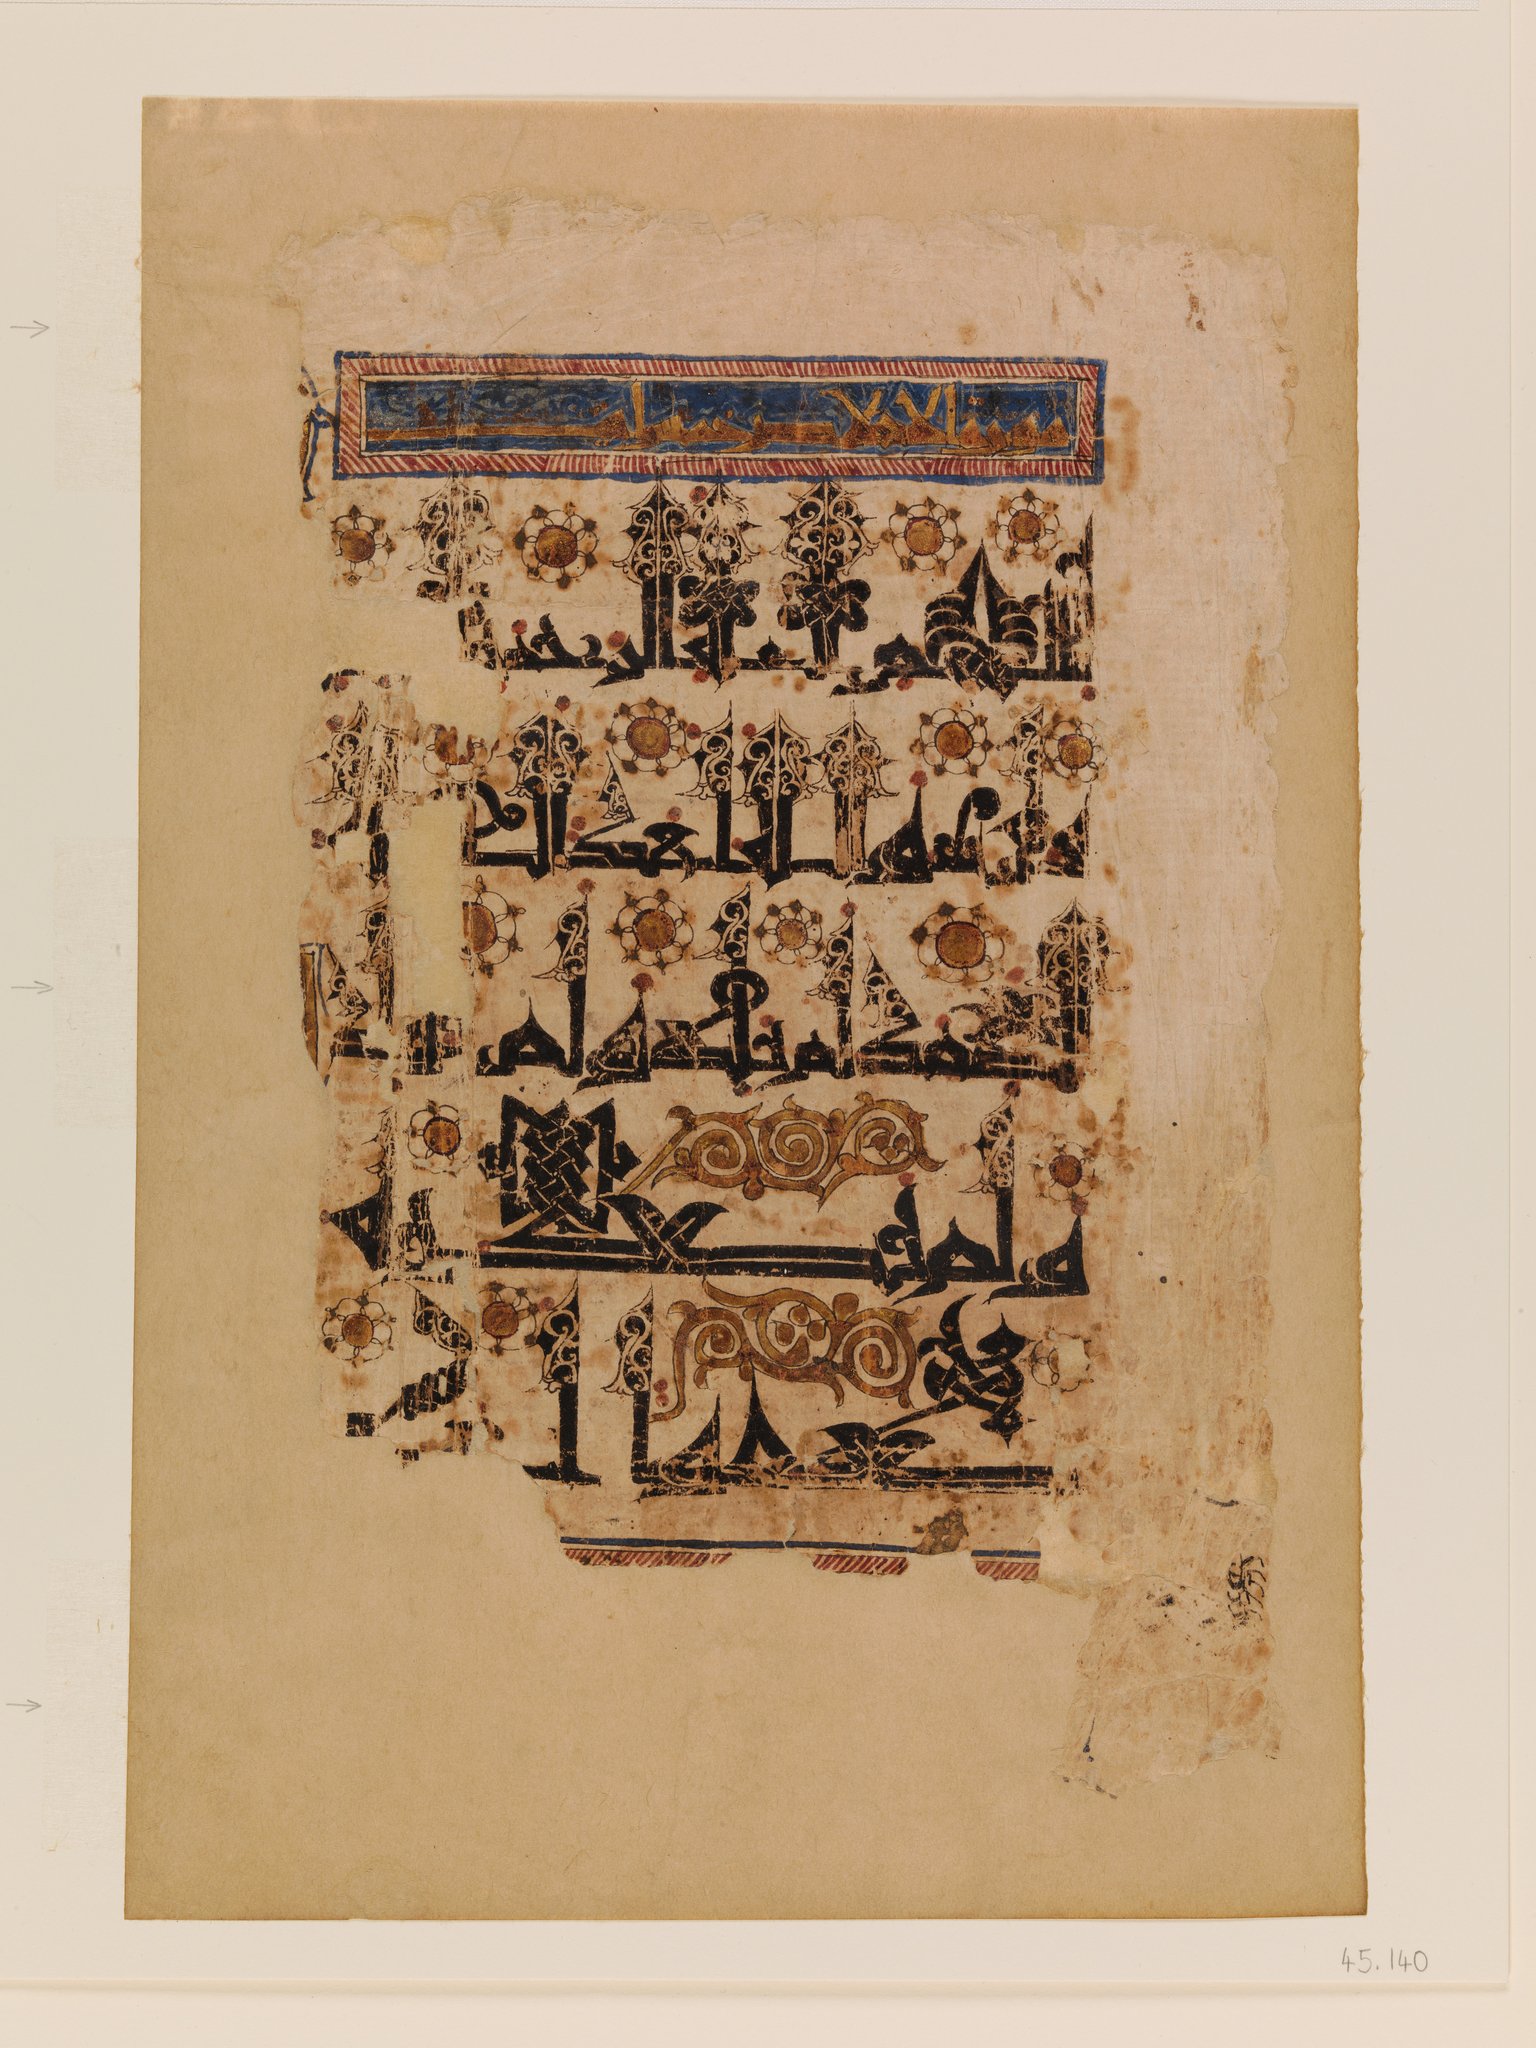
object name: folio from a non illustrated manuscript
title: Folio from a Qur'an Manuscript in Floriated Script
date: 1001-1100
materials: gold, ink, paper, watercolor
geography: iran